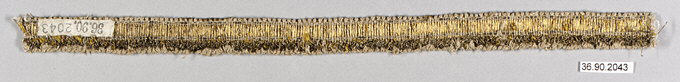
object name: galloon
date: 1601-1700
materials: metal thread, silk